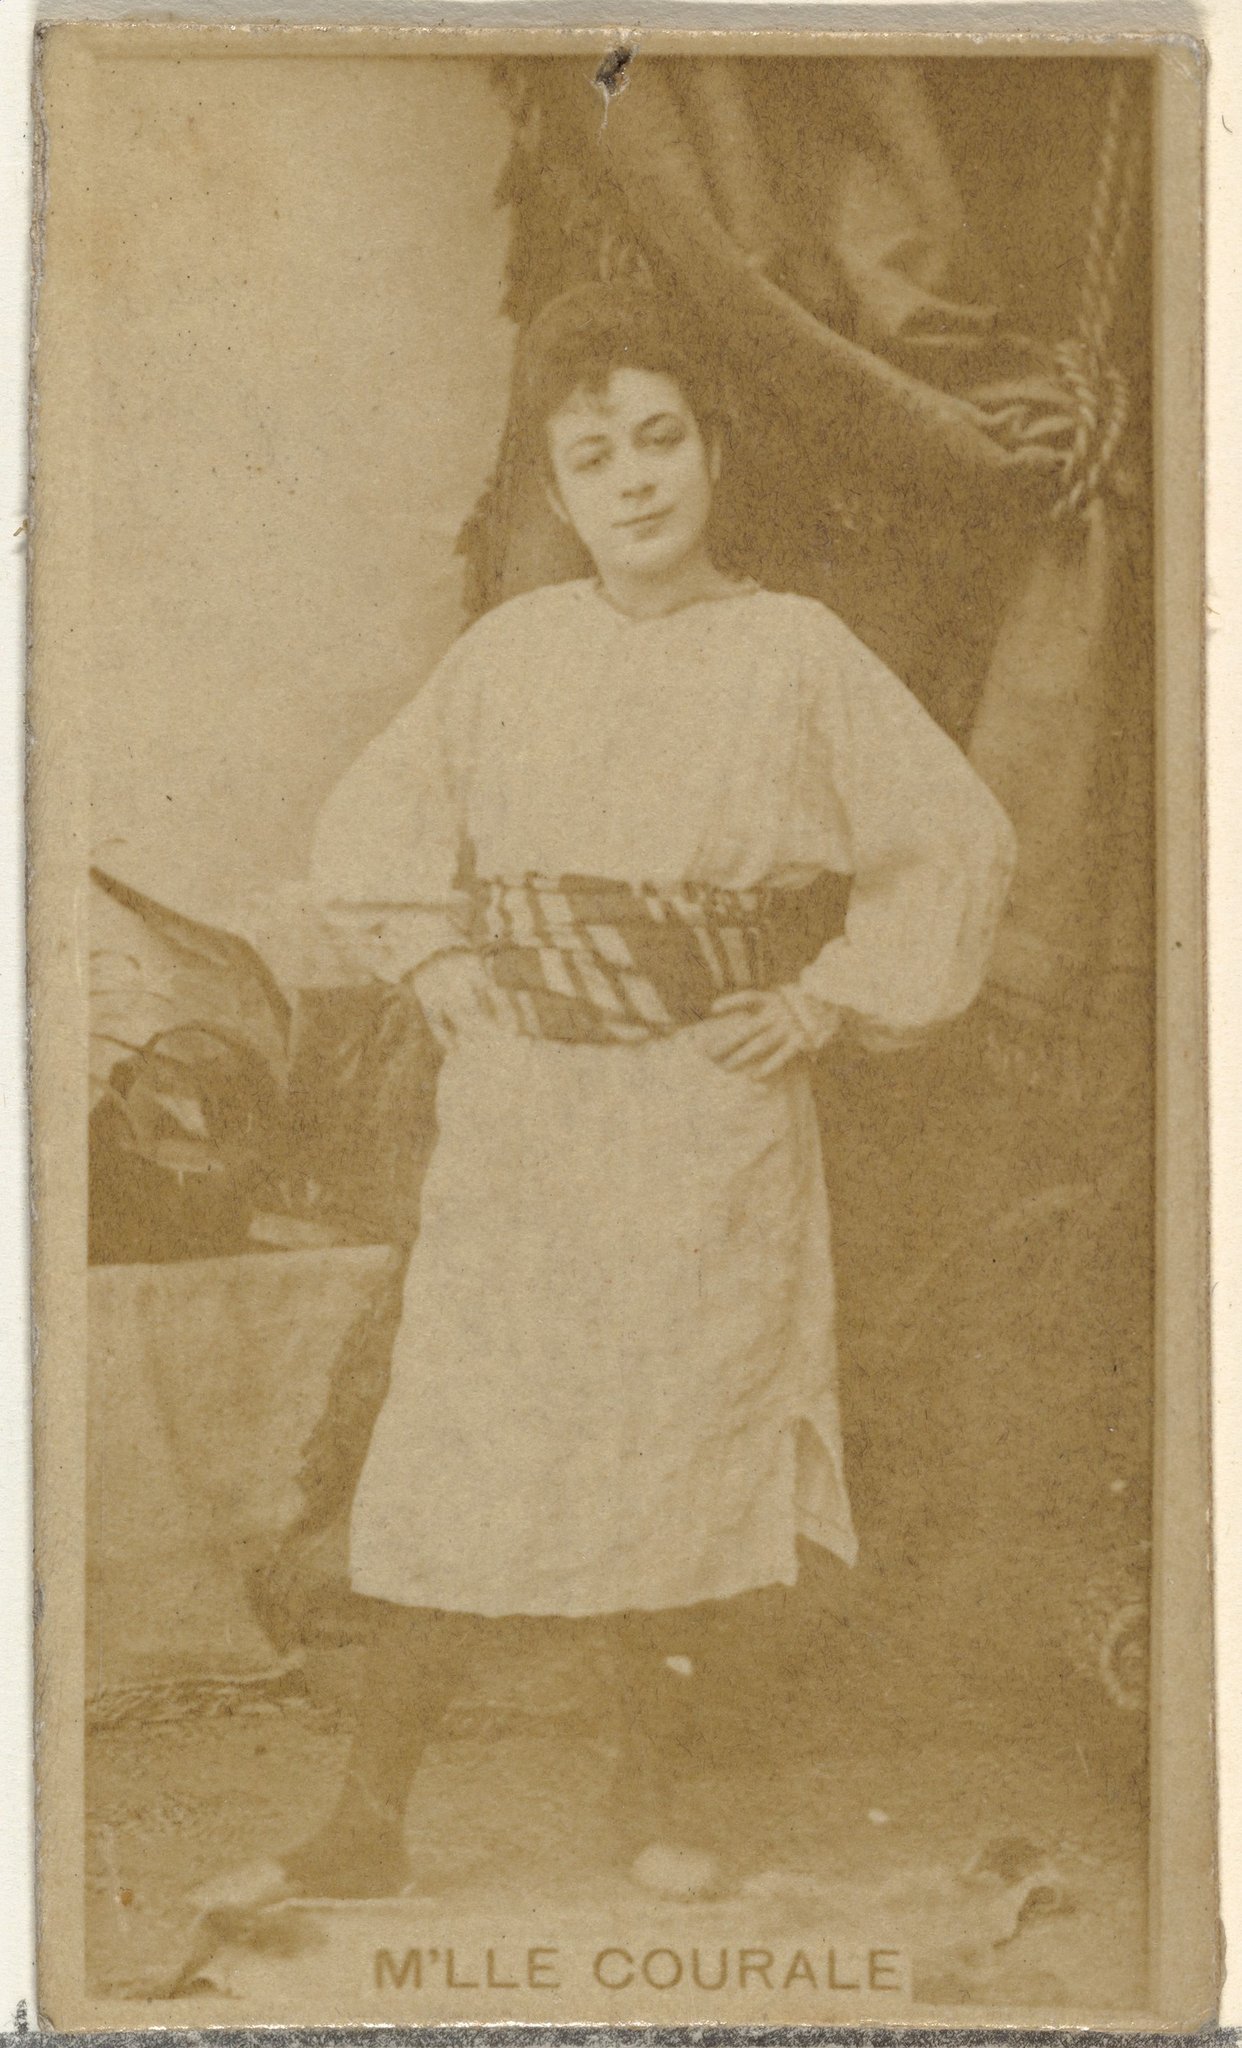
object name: photograph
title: M'lle Couralet, from the Actors and Actresses series (N145-8) issued by Duke Sons & Co. to promote Duke Cigarettes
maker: w. duke, sons & co.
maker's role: publisher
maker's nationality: american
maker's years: 1870-1920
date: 1891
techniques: albumen silver print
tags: portraits,women,actresses